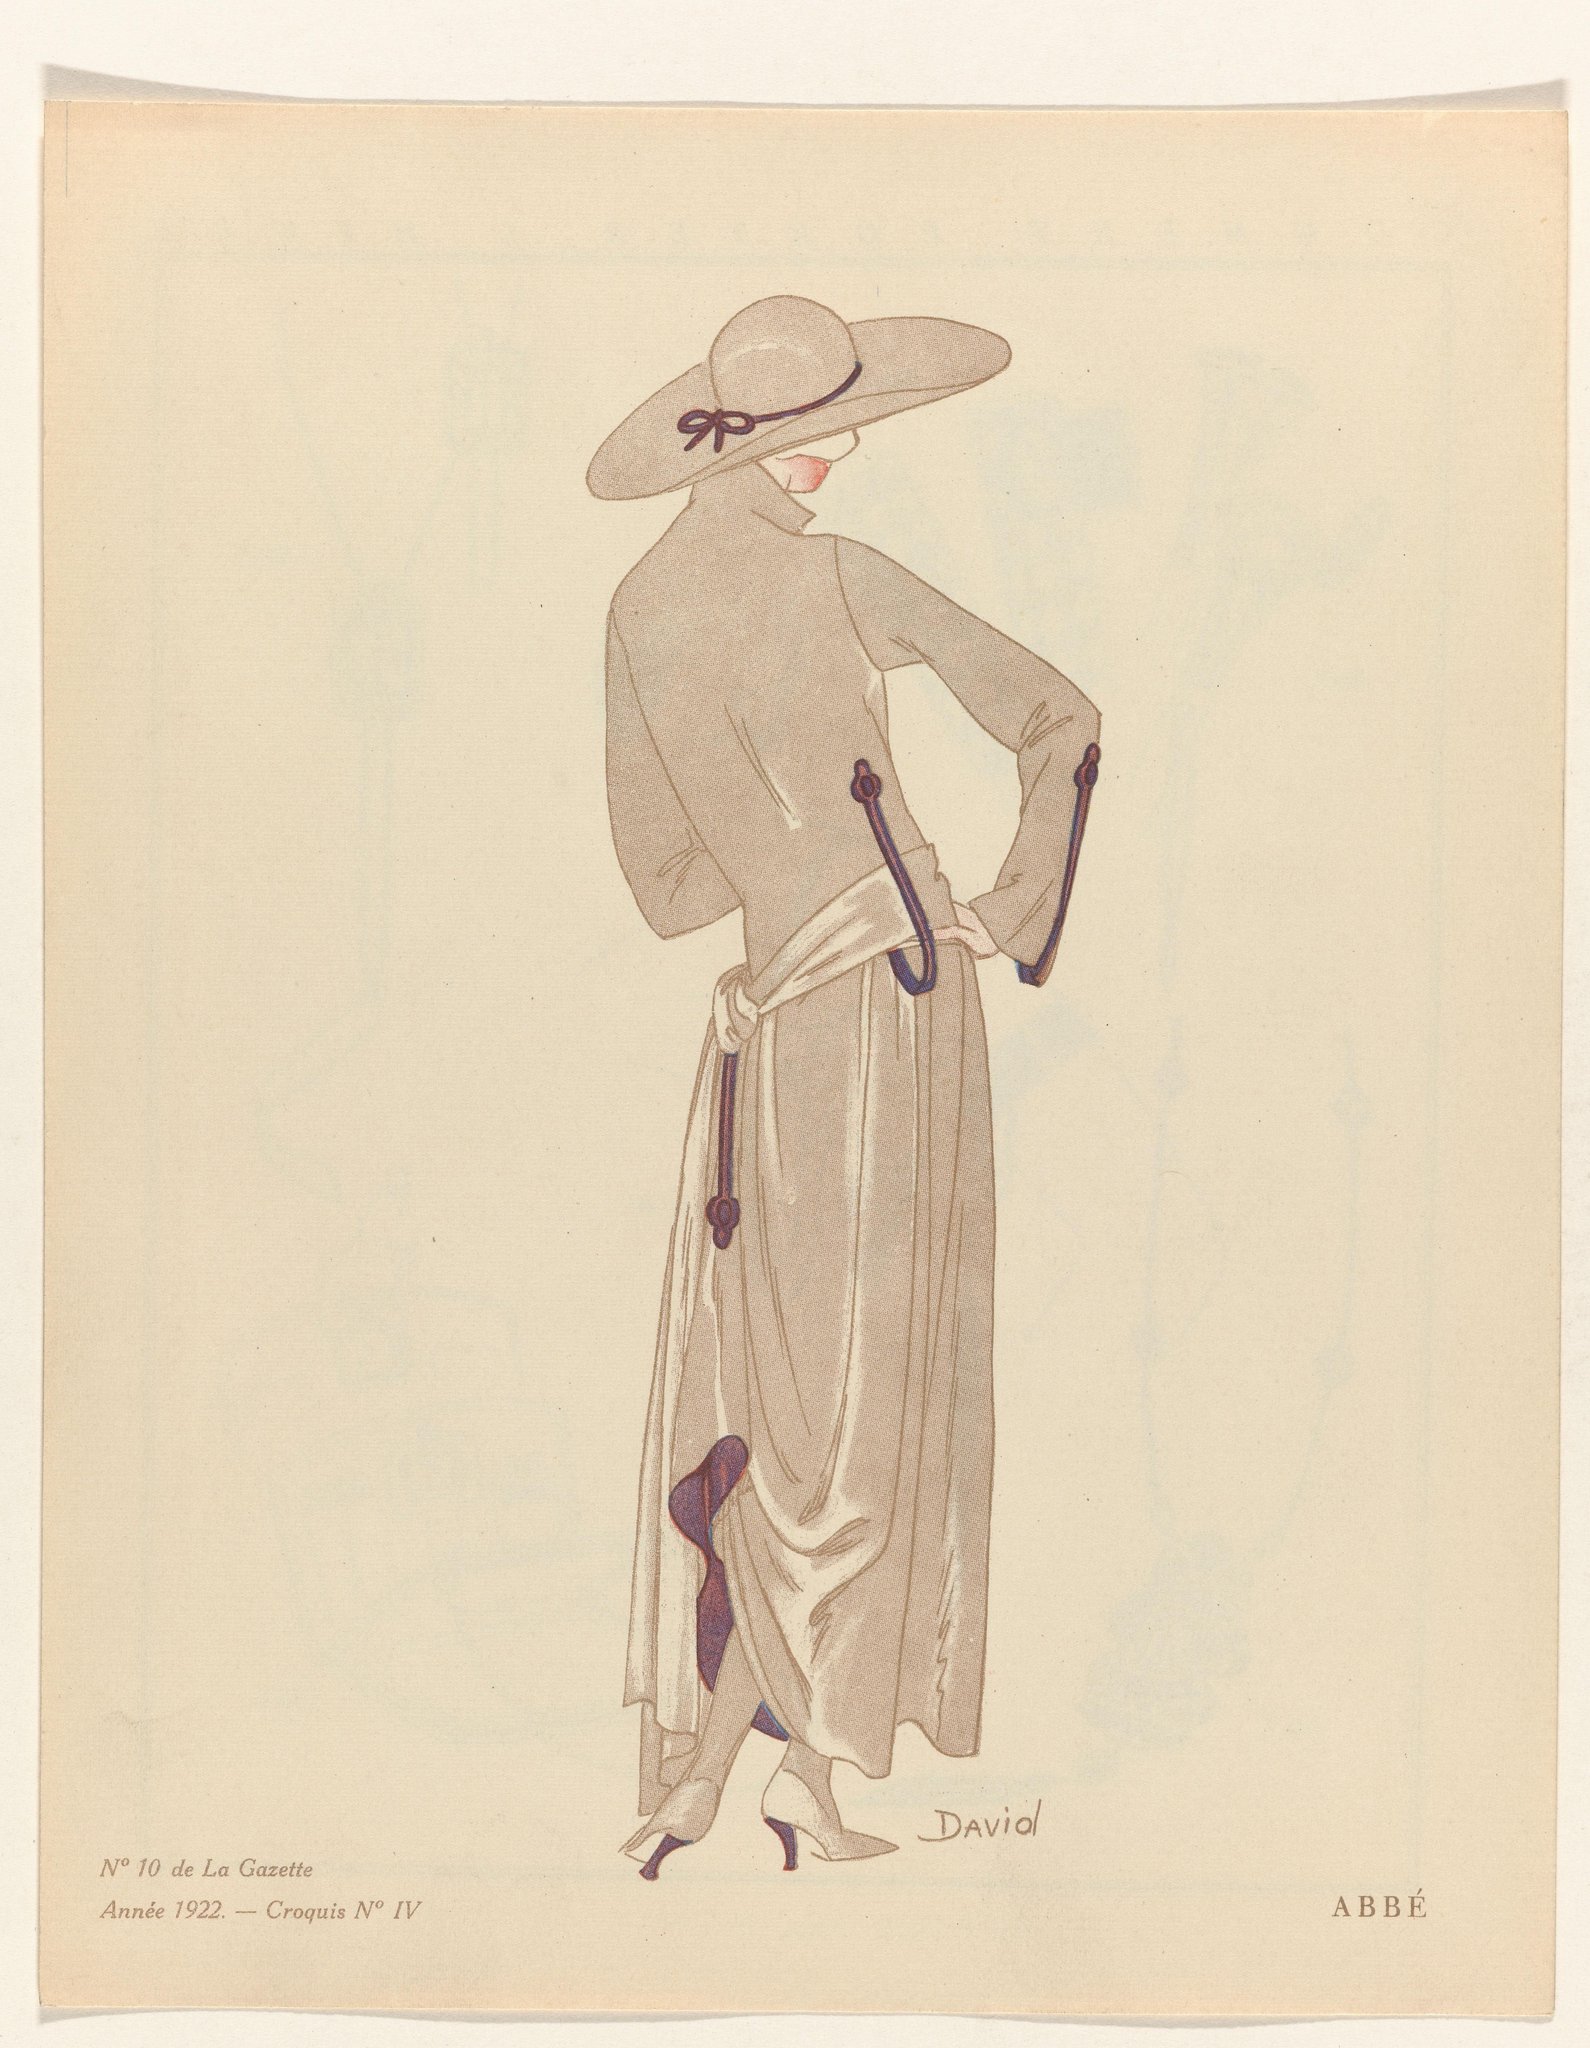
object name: fashion print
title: Gazette du Bon Ton, 1922, No. 10, Pl. IV: Abbé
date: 1922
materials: paper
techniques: printing, letterpress printing, photochemical processes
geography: paris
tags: head-gear (+ women's clothes), fashion plates, dress, gown (+ women's clothes), belt, girdle, waistband (+ women's clothes)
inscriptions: date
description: Japon met ceintuur; geïnspireerd op het kostuum van een abt. Ronde hoed met brede rand. Croquis No. IV uit Gazette du Bon Ton 1922, No. 10. Uitleg over de kleding op pagina "Description et explication des planches hors-texte et pages de croquis."